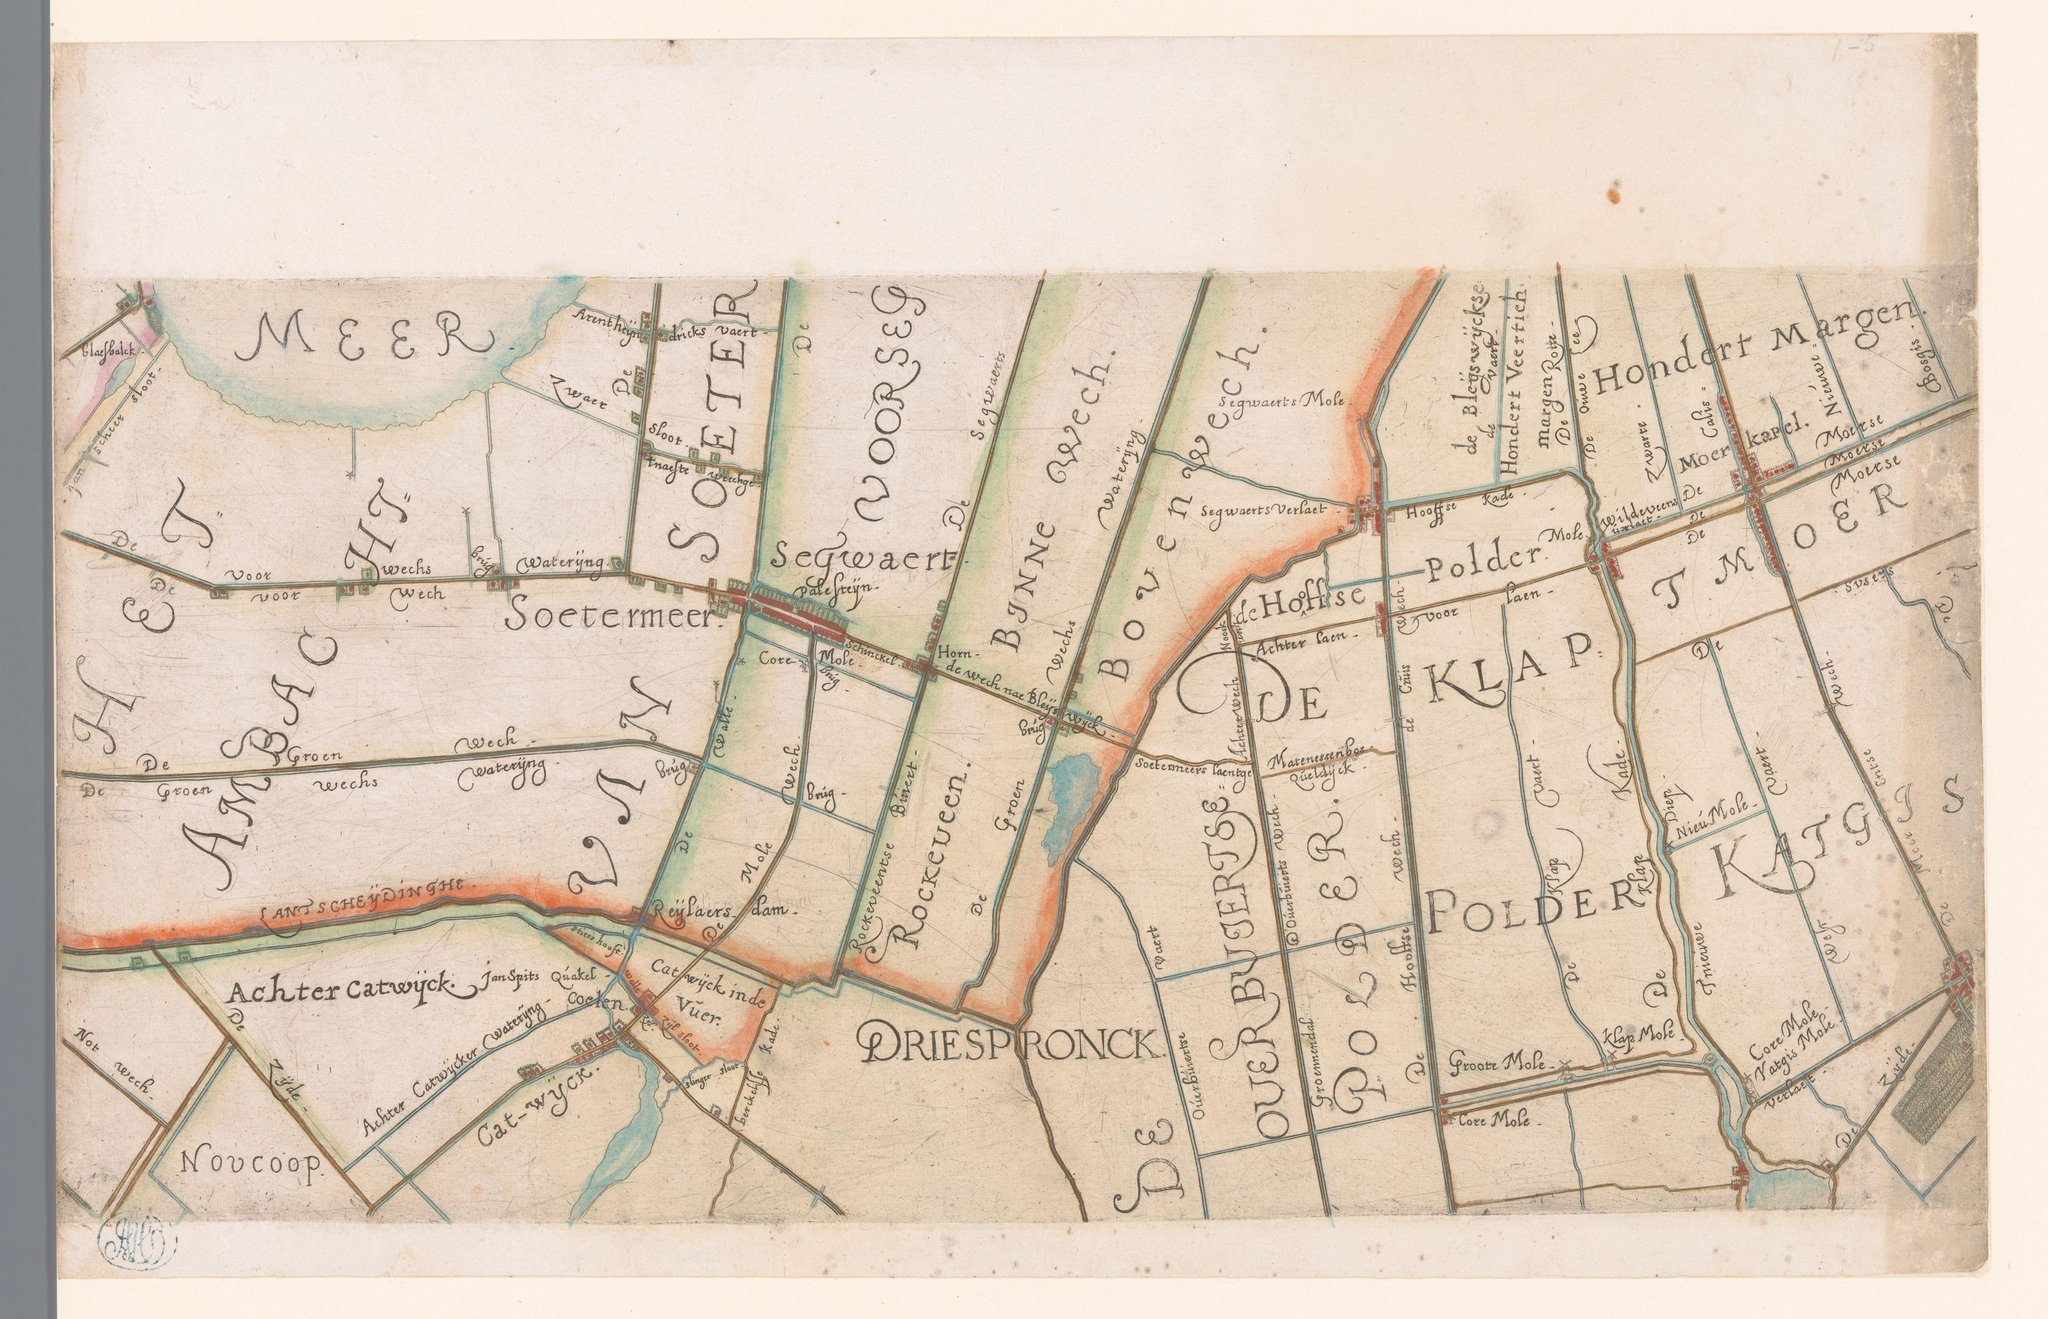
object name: print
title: Deel van een kaart van het Hoogheemraadschap van Rijnland, met Zoetermeer en omgeving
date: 1615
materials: paper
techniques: engraving, etching, hand coloring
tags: maps of separate countries or regions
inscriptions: collector's mark: Lugt 195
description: Deel van een kaart van Rijnland, bestaande uit 27 delen.